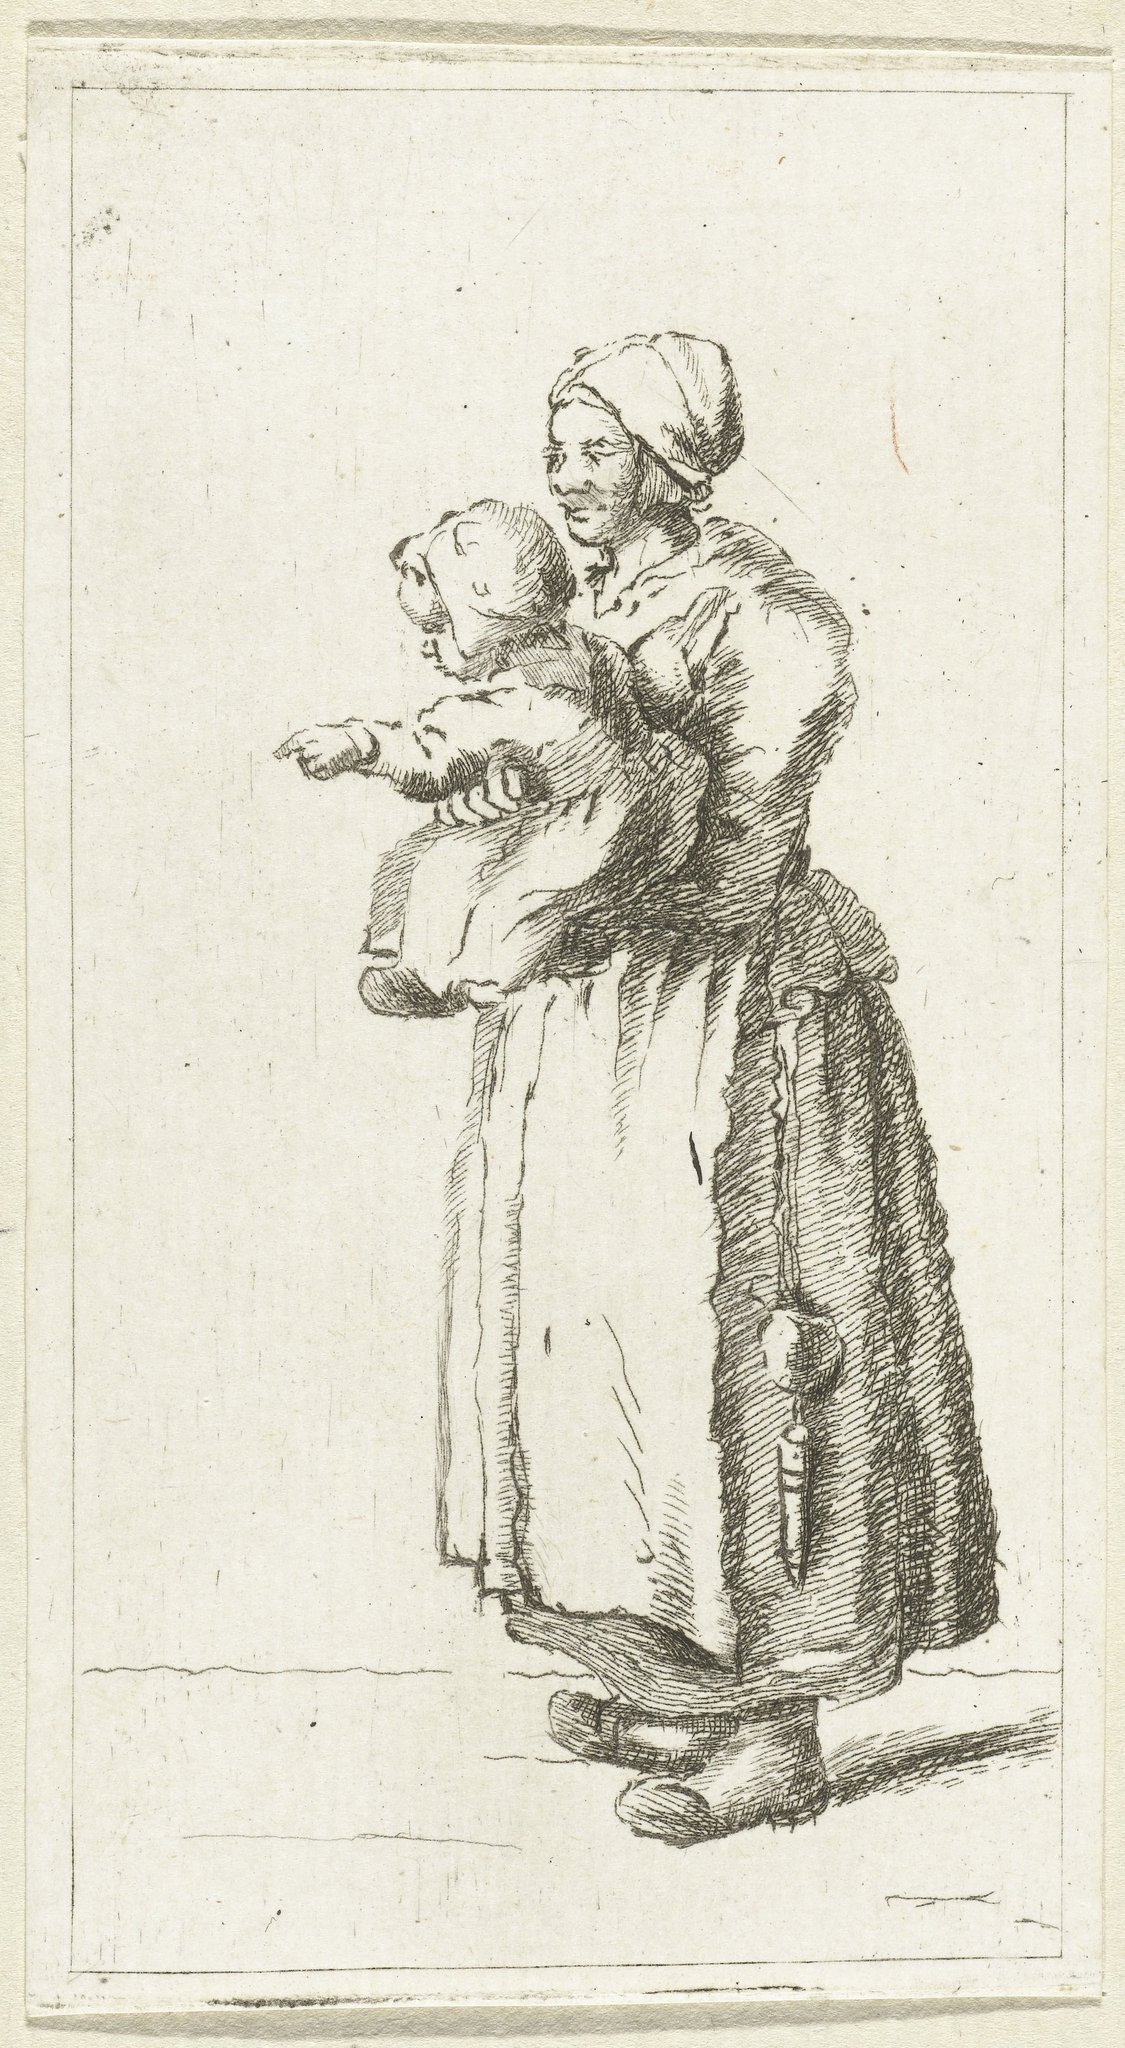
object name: print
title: Staande moeder met kind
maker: pieter de mare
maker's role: print maker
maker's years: 1758-1796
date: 1779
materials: paper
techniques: etching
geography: leiden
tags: mother and child(ren), woman and child(ren) (family group) (with number of children)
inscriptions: collector's mark: Lugt 2233